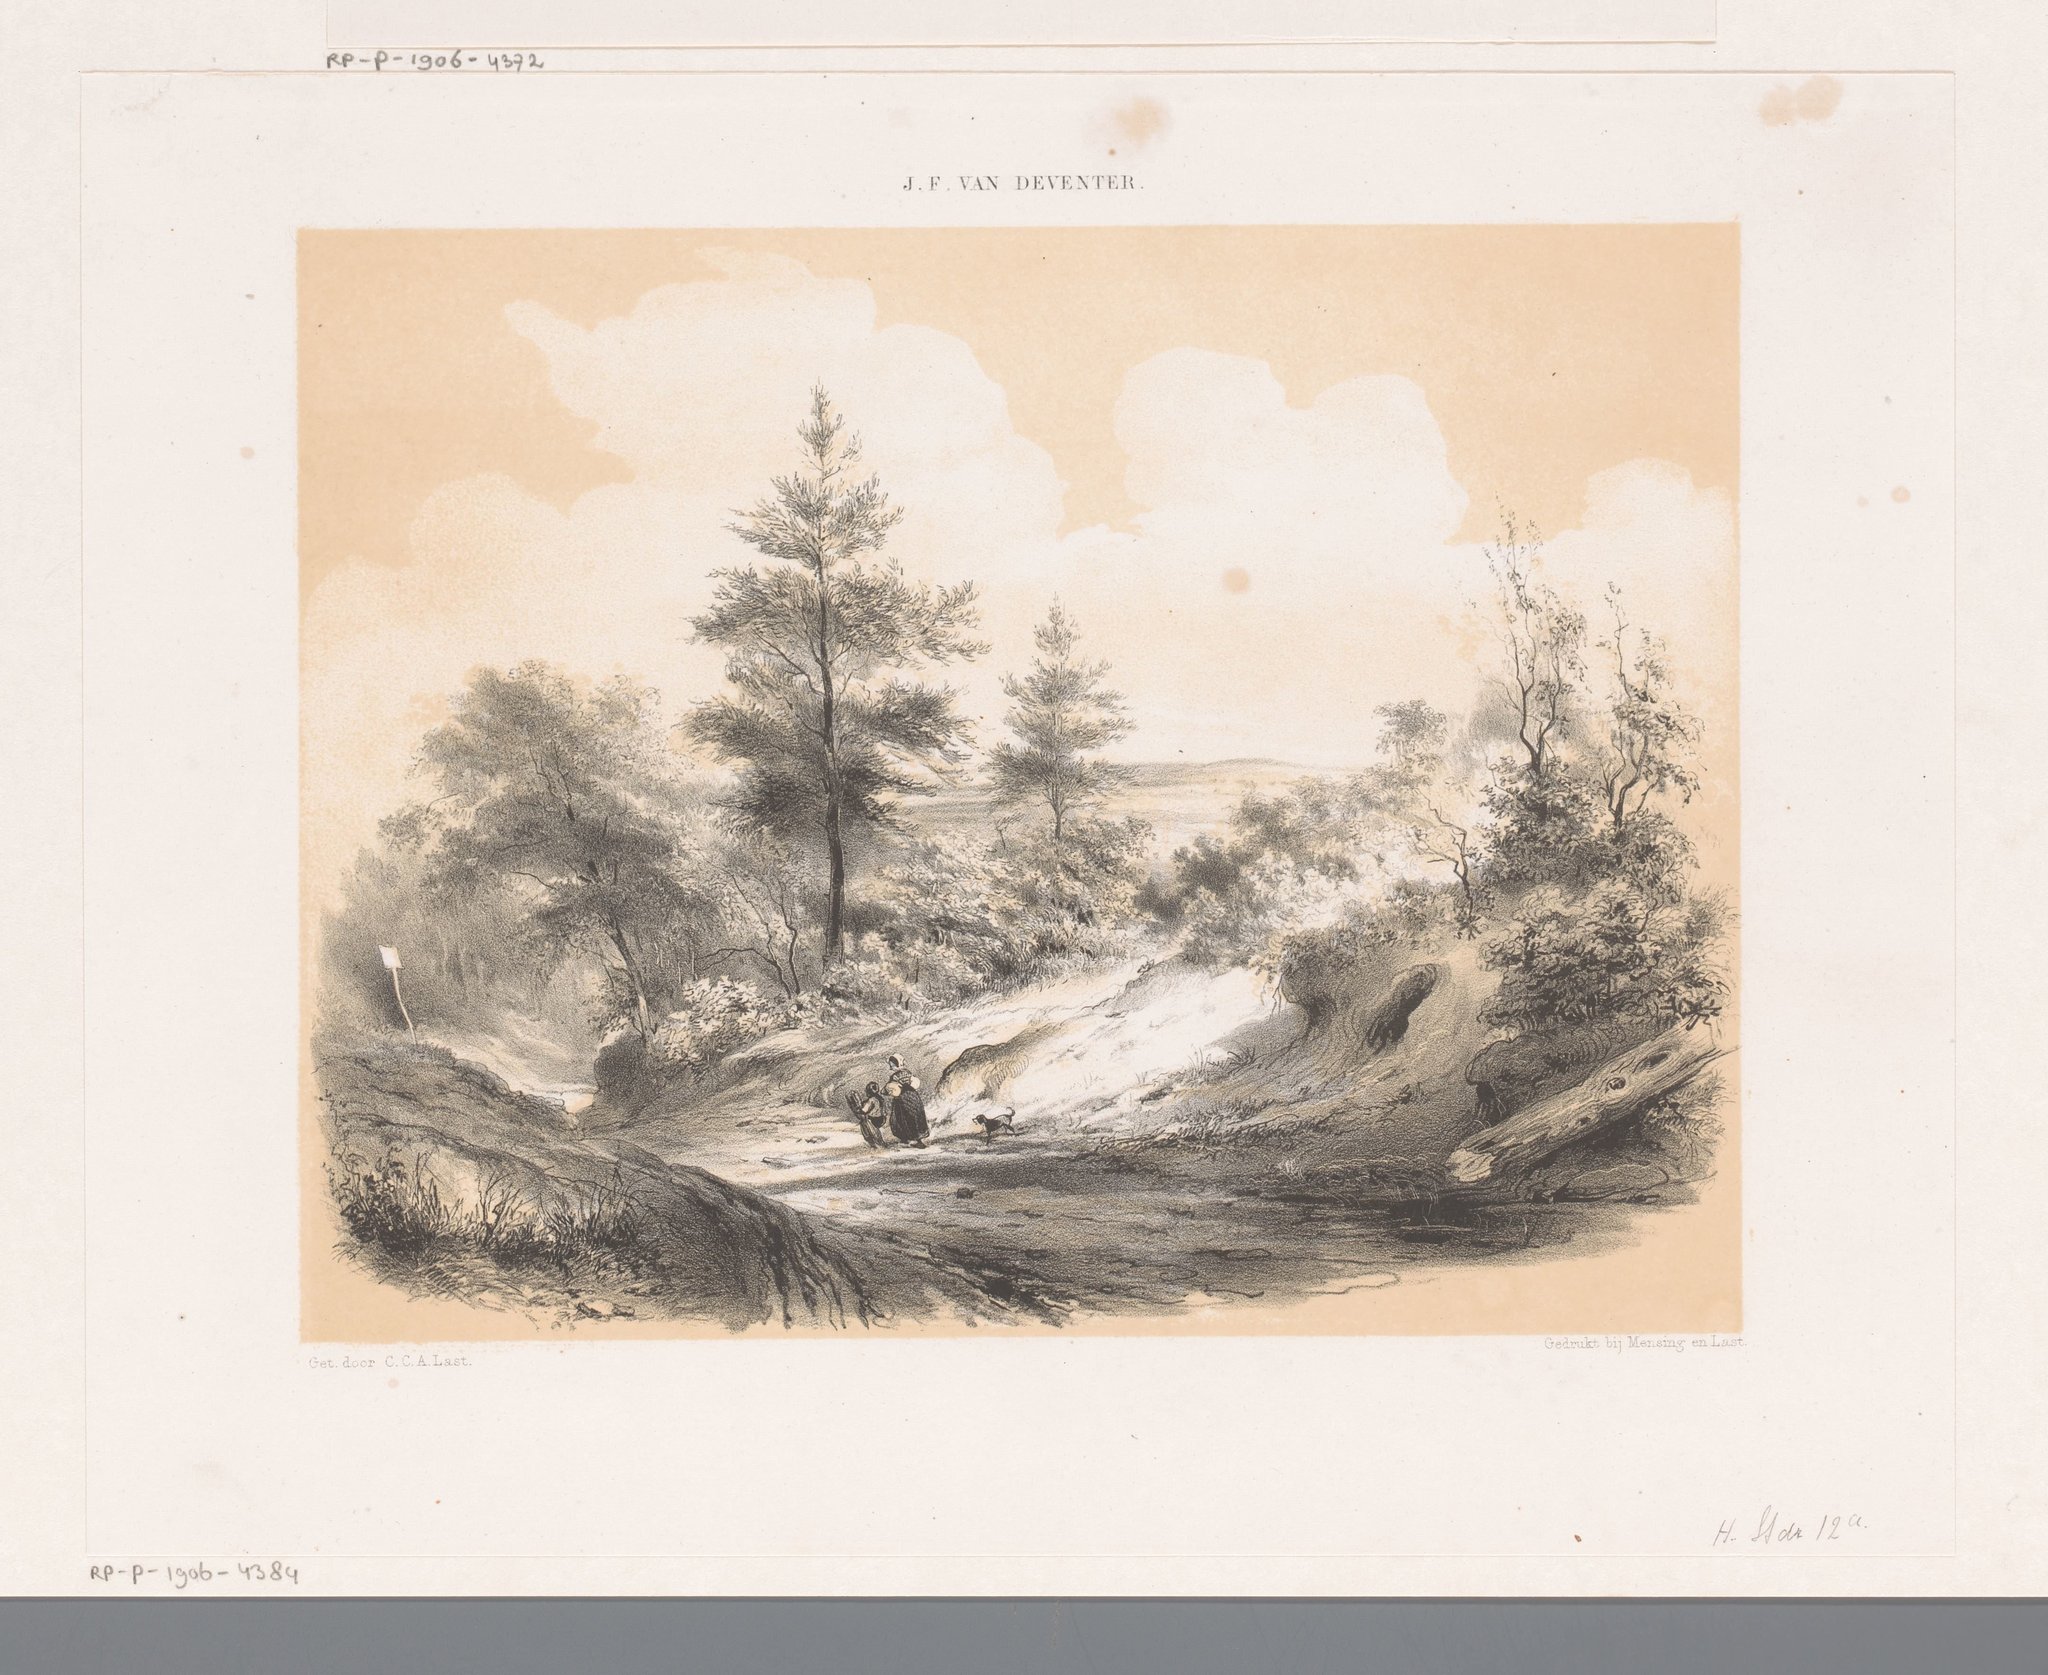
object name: print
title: Zandweg door heidelandschap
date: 1841-1847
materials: paper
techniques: tone lithography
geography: the hague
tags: road, path, plain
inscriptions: collector's mark: Lugt 2228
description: Op de weg lopen een vrouw, kind en hond.